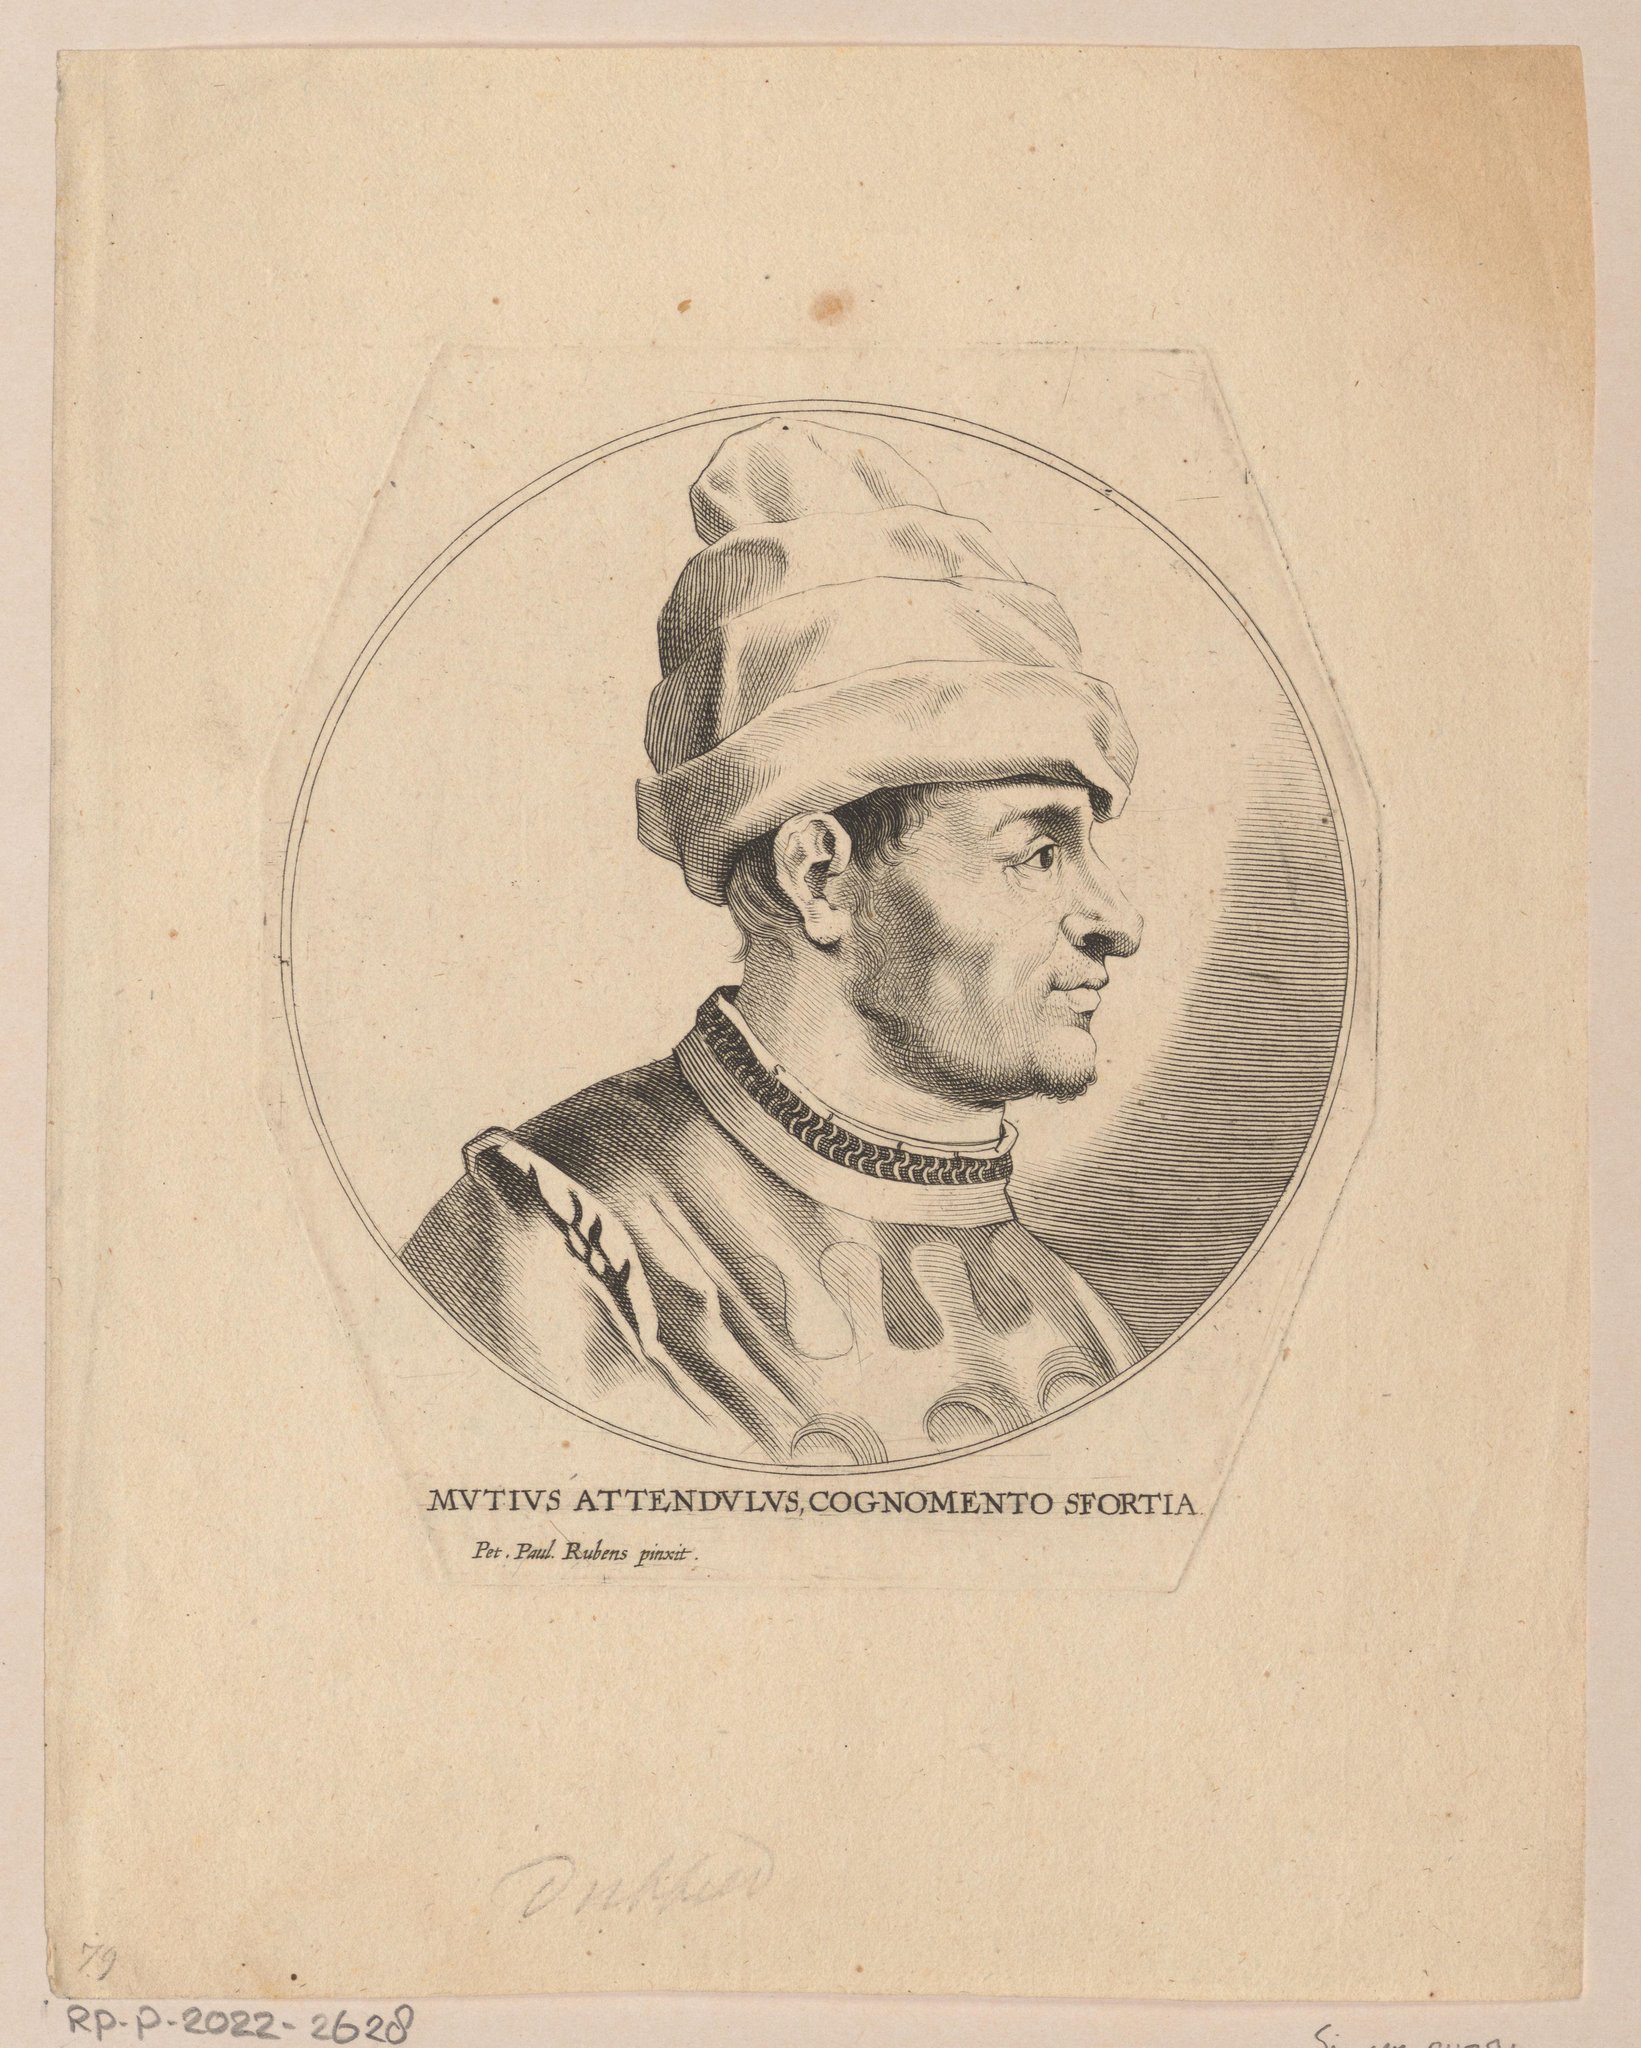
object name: print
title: Portret van Muzio Attendolo Sforza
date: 1619-1675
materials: paper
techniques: engraving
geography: antwerp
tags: historical persons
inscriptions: inscription: ‘S[...] pag. 186 No 275 / Mutius Attendolo Sforza / graaf van Cotegnolo / condotierre 1369 - 1424’, collector's mark: Lugt 2228